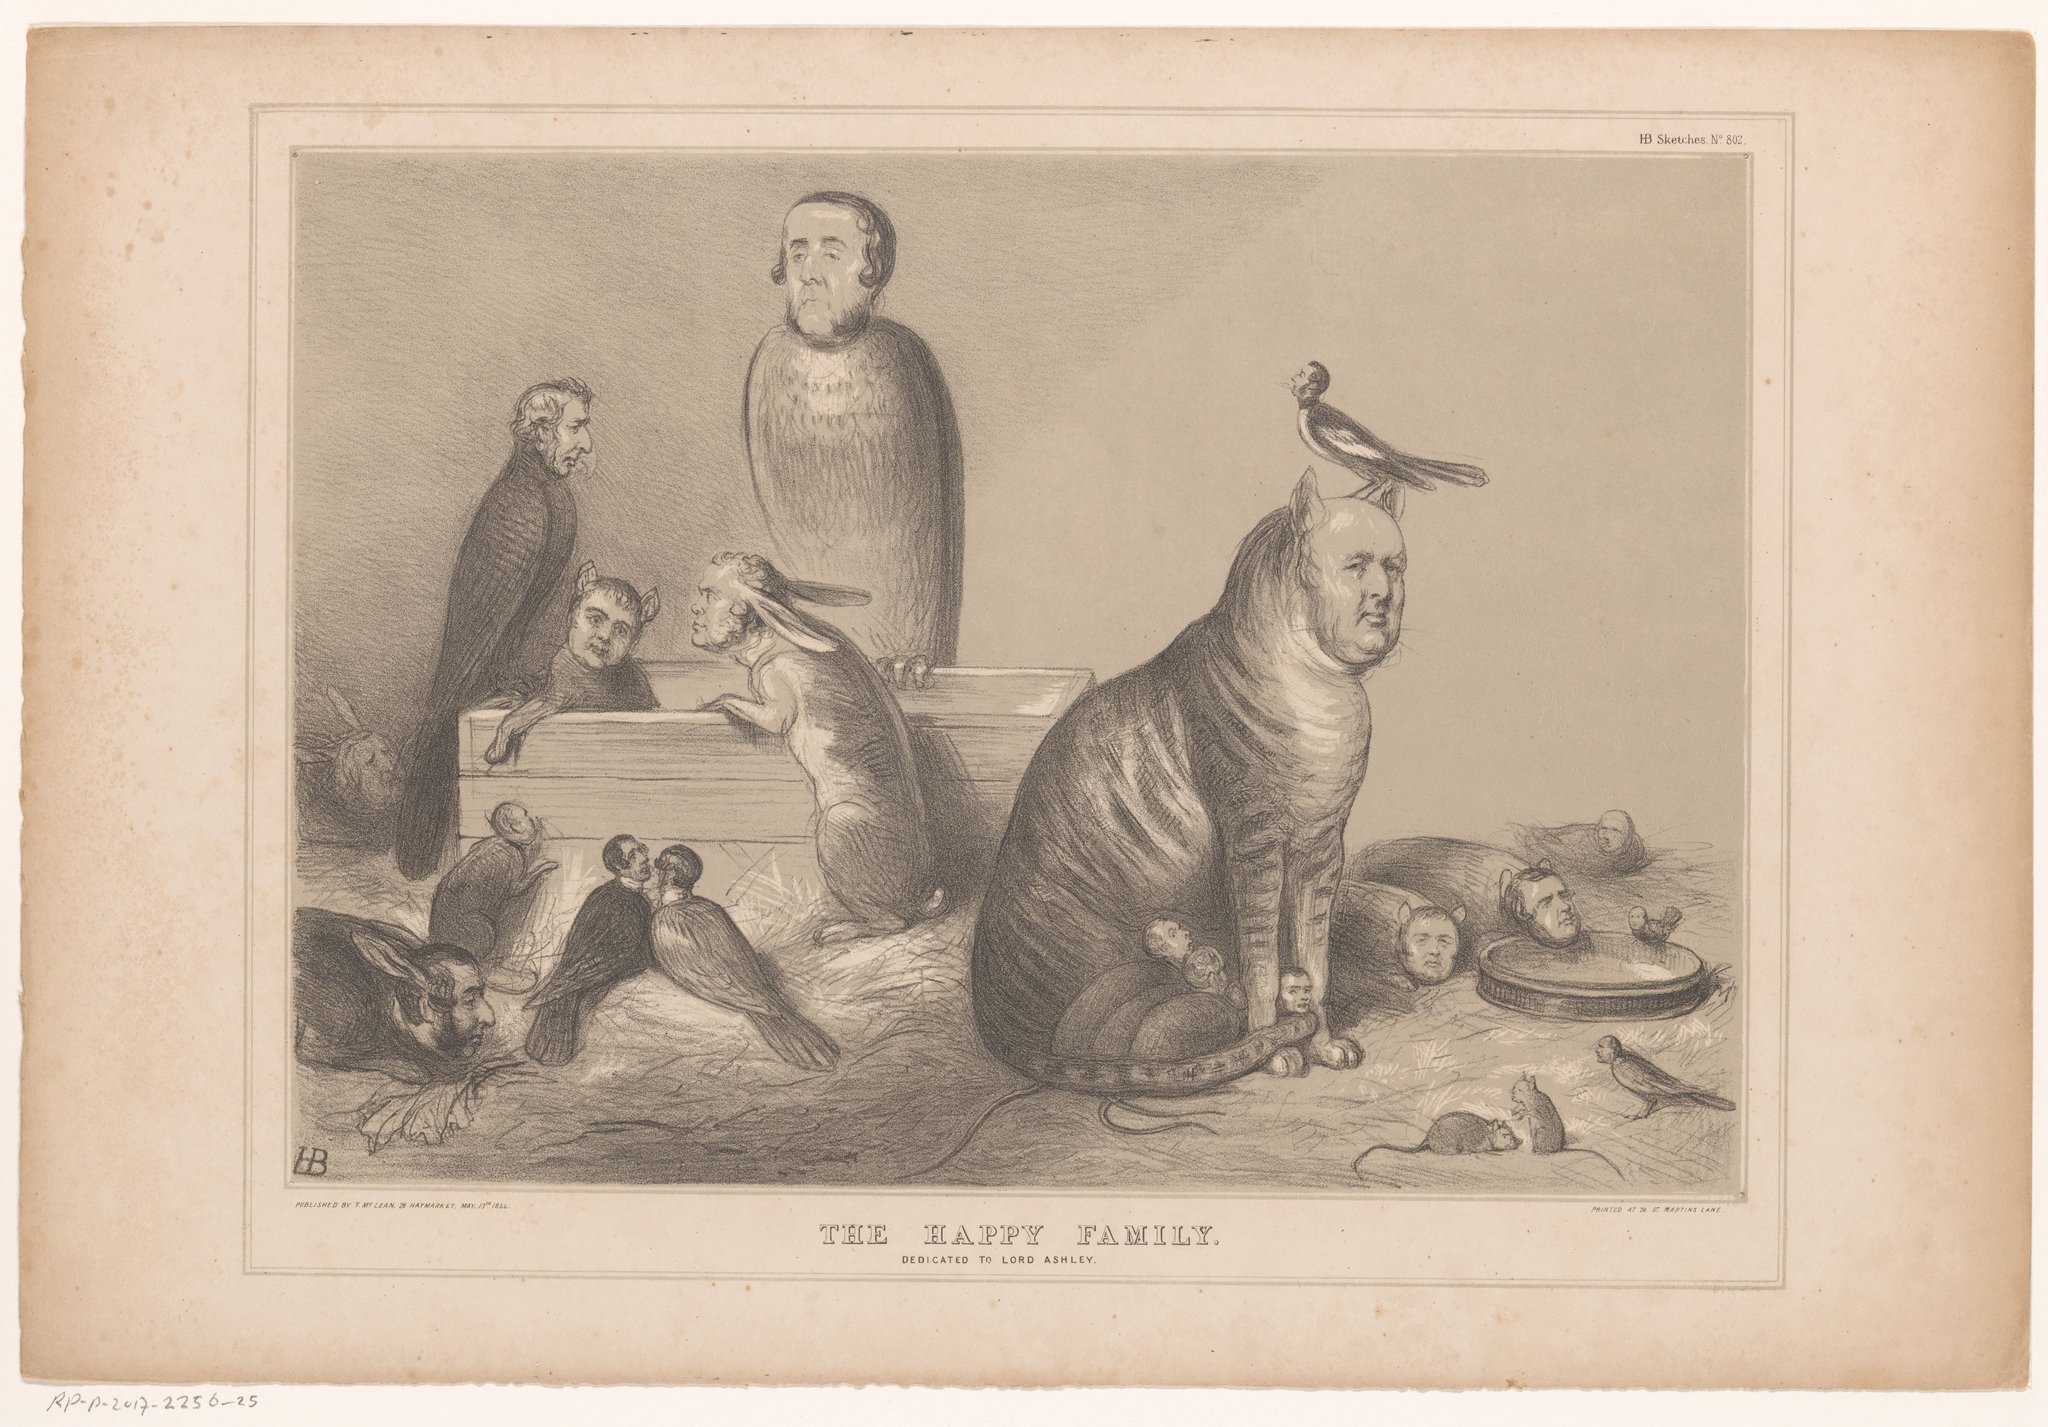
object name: print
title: HB Sketches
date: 1844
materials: paper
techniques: tone lithography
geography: london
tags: anthony ashley-cooper (7th earl of shaftesbury), politician, owls, cat and mouse, political caricatures and satires, doves, pigeons, rodents: rabbit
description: Spotprent over Engelse binnenlandse politiek in 1844 met Lord Asley voorgesteld als een uil en Sir Robert Inglis als een kat zittend in het stro tussen de muizen, vogels en konijnen. Alle dieren hebben de hoofden van politici. Uitgegeven als nr. 802 in de serie HB Sketches.